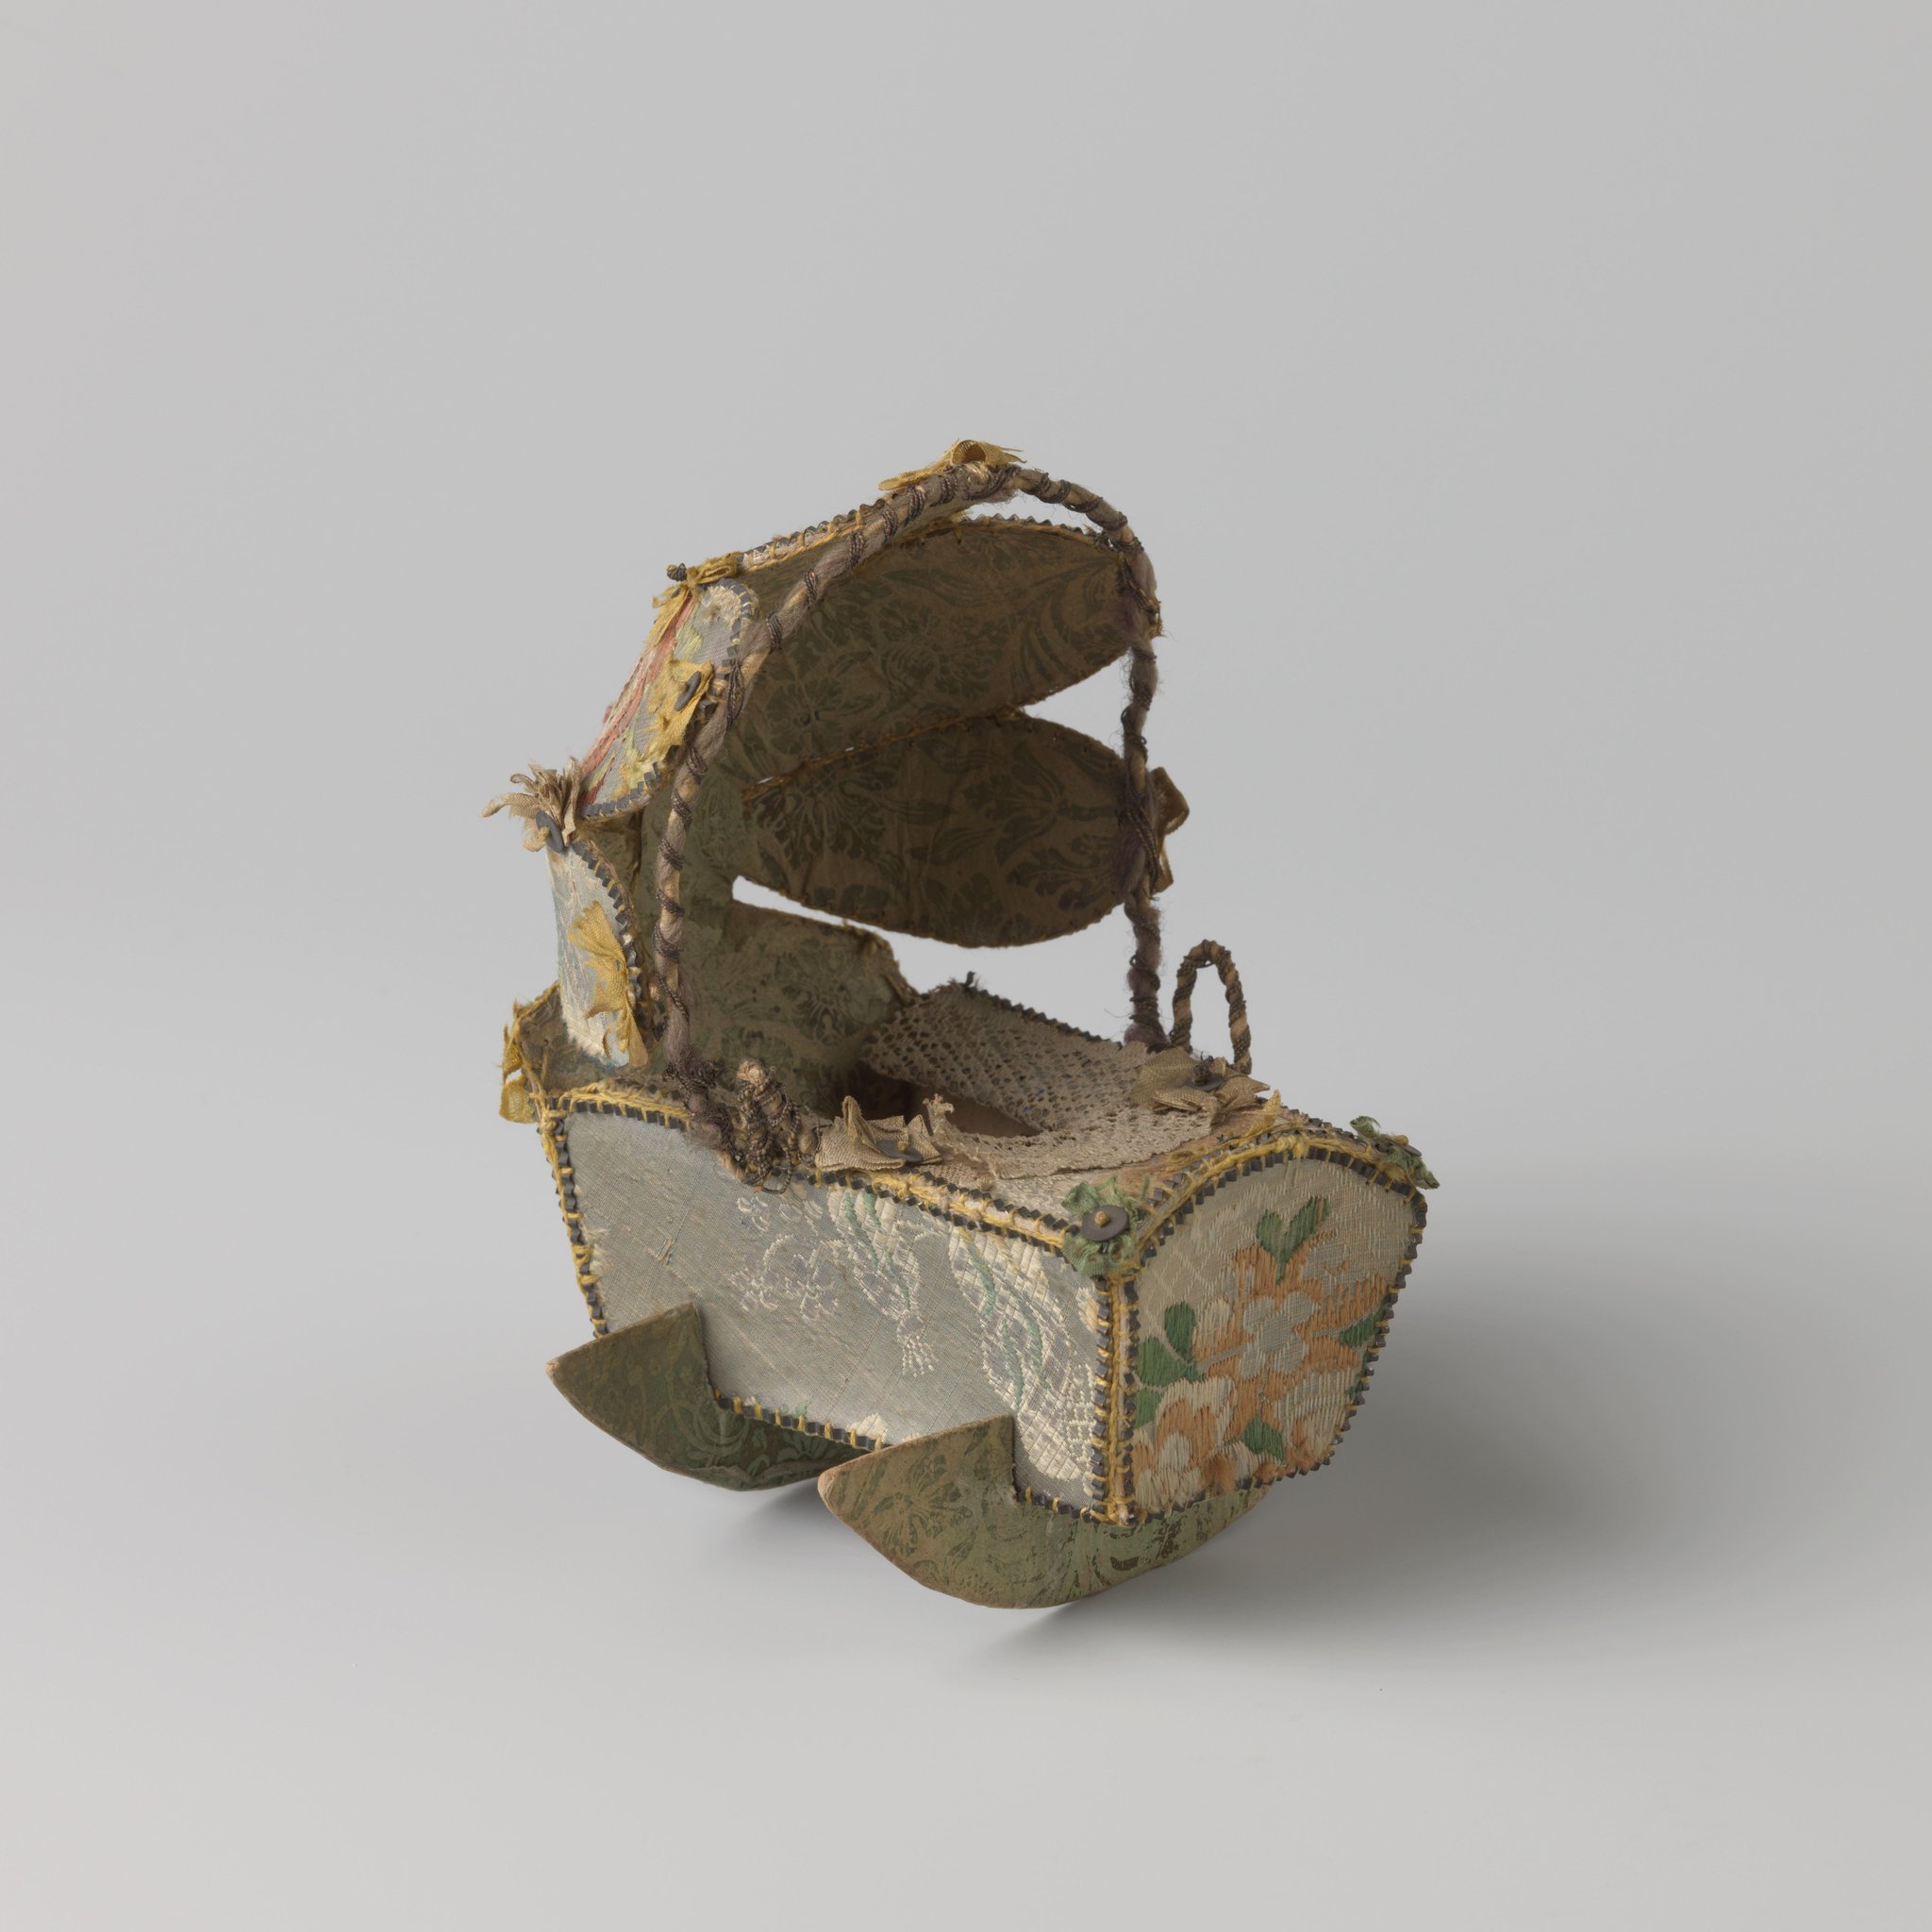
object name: wieg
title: Poppenhuiswieg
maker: Anonymous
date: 1400-1950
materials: cardboard, textile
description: Poppenhuiswieg met geborduurde bloemen op de kap en de wieg.